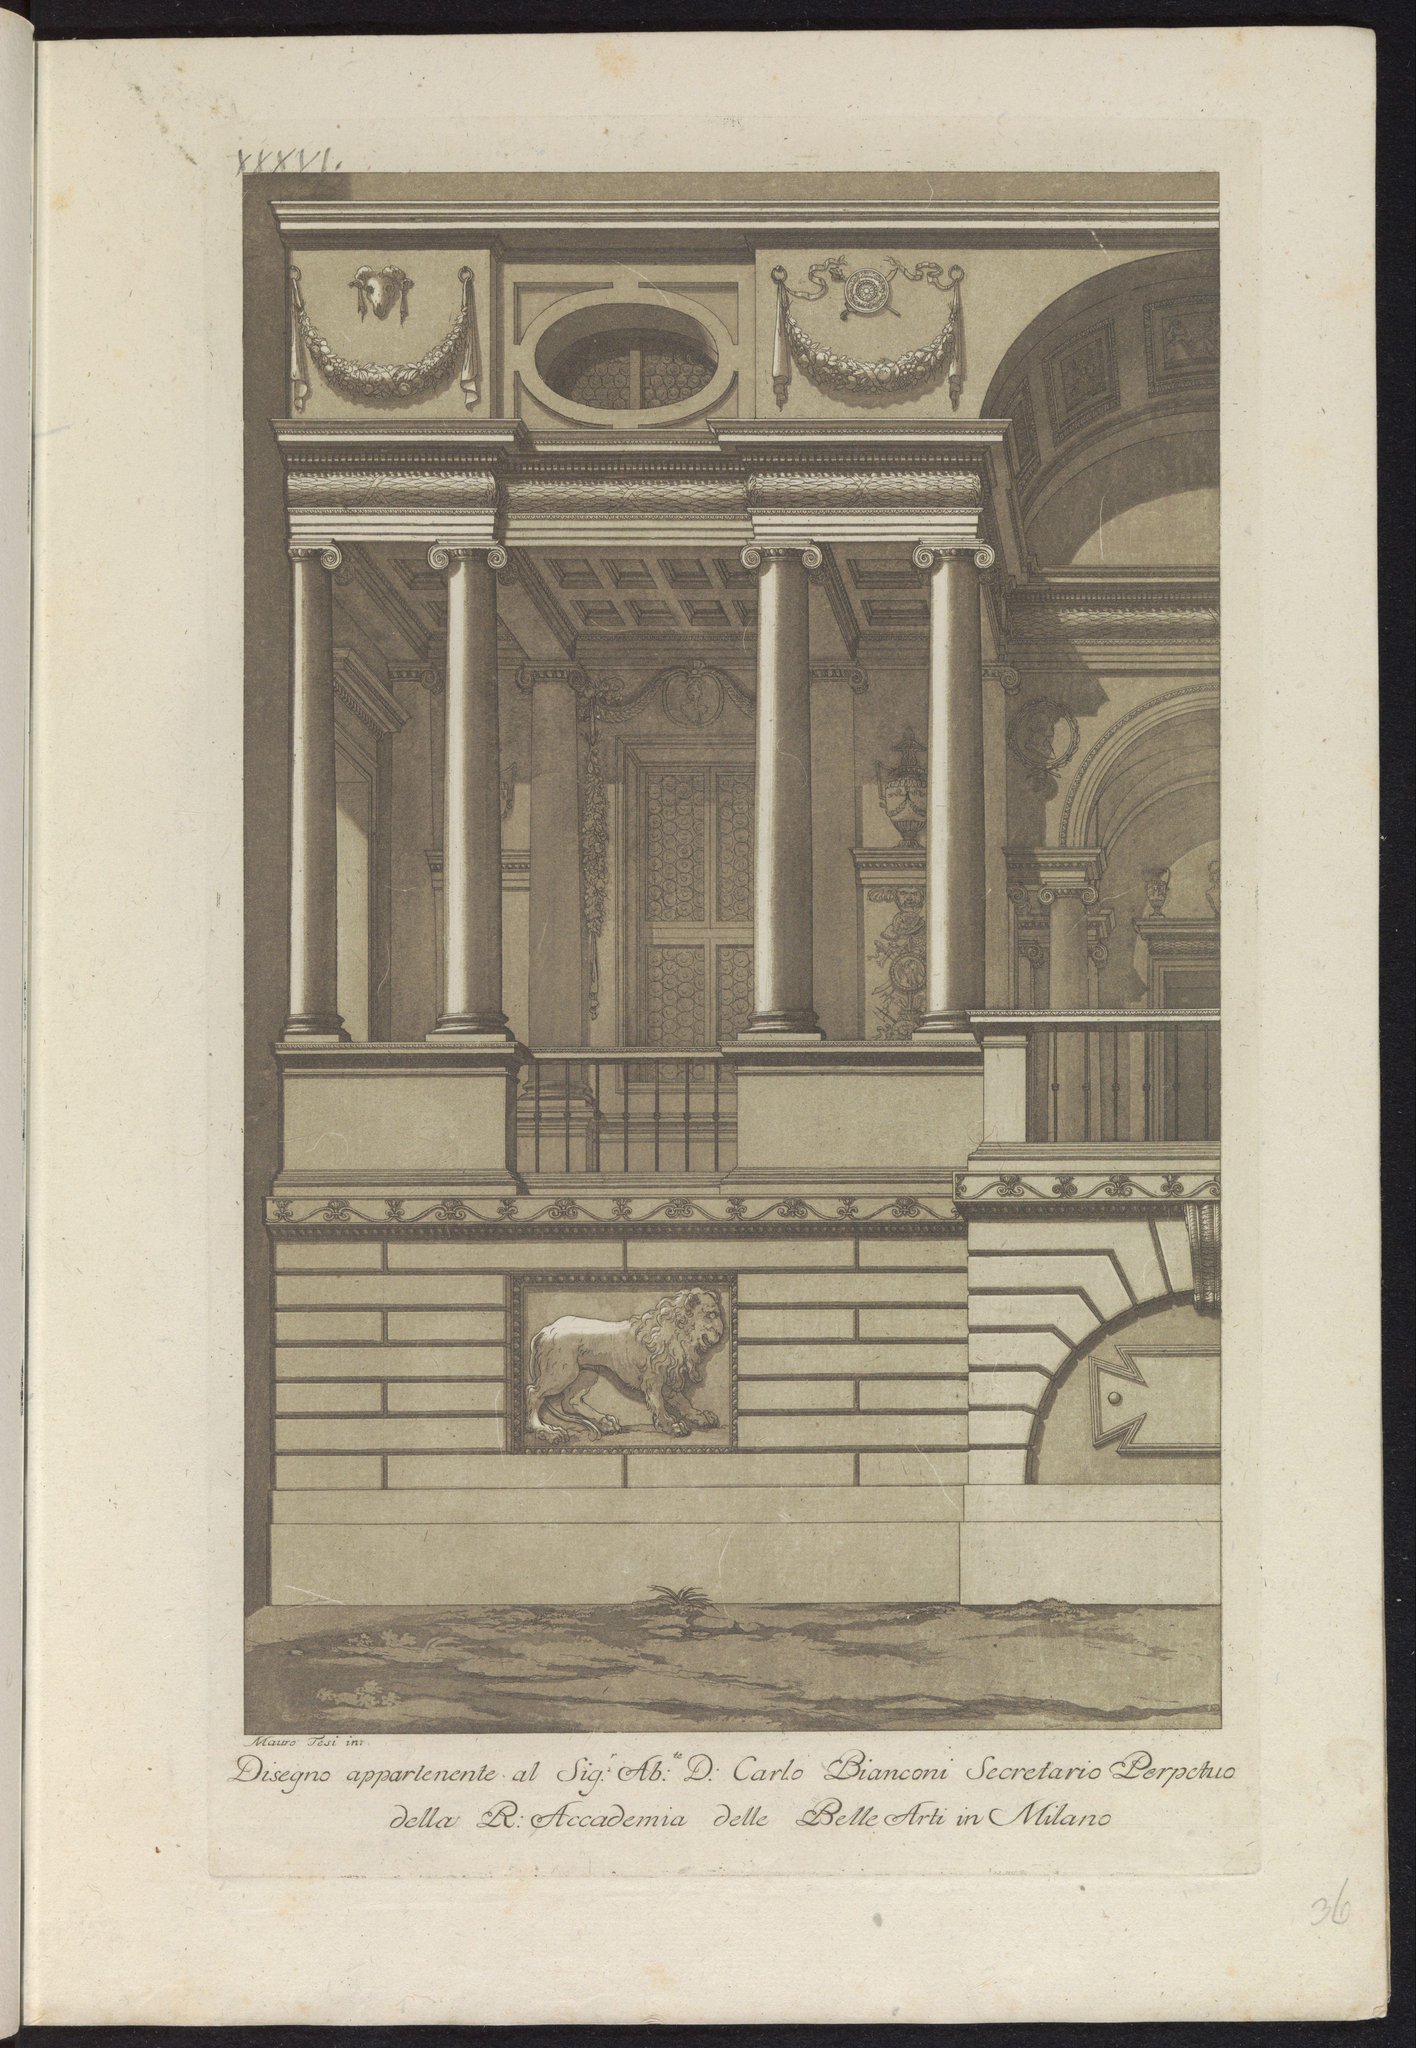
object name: print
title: Ingangspartij met reliëf van een leeuw in het basement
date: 1787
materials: paper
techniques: aquatint, etching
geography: bologna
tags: beasts of prey, predatory animals: lion